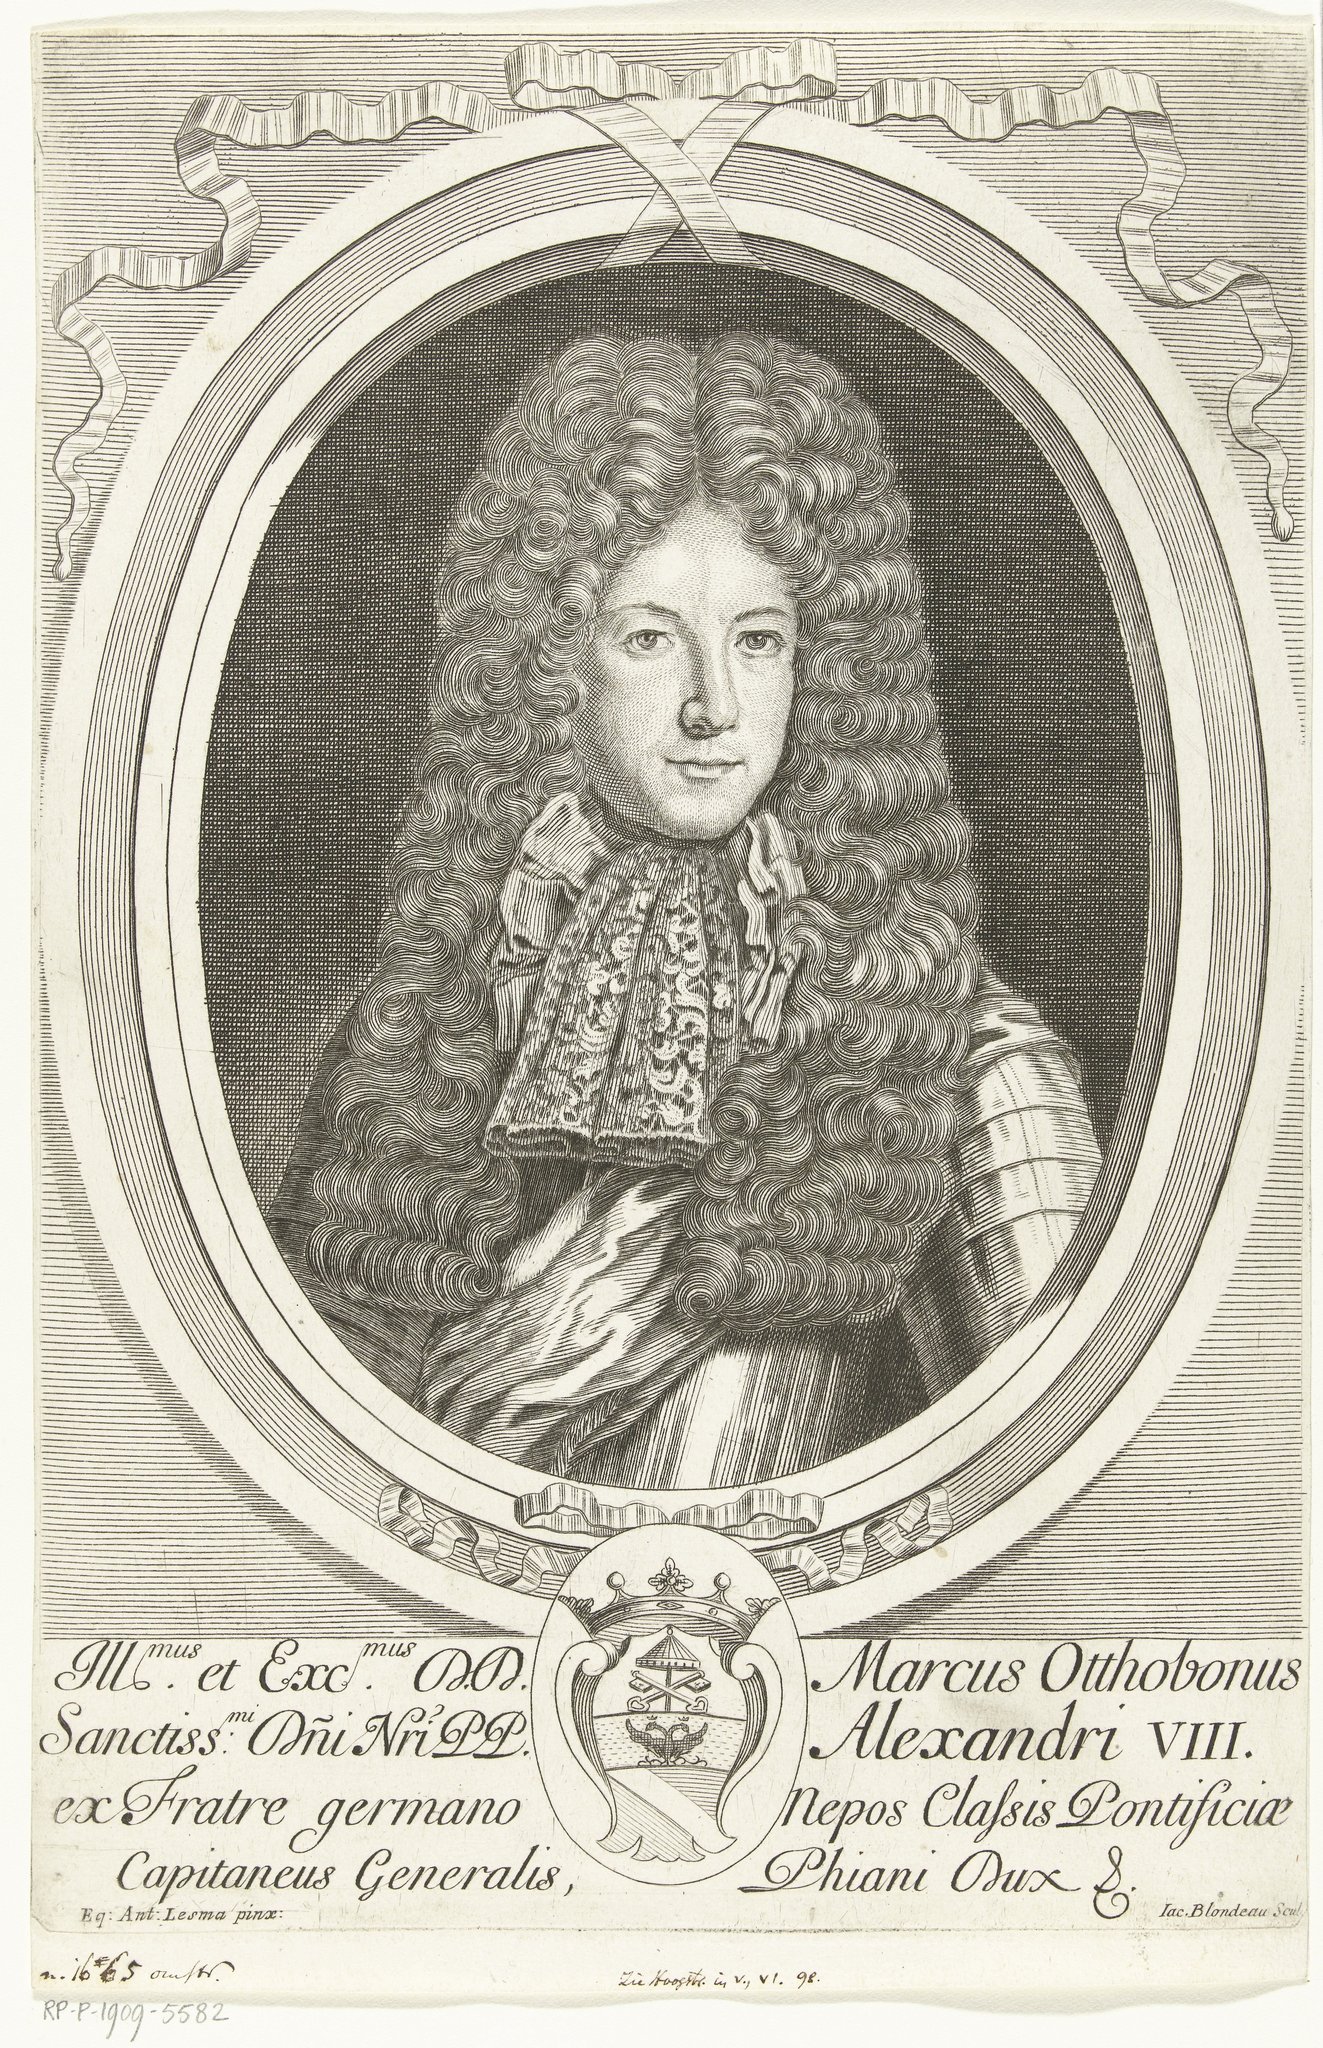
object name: print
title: Portret van Marco Ottoboni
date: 1665-1698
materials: paper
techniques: engraving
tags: marco ottoboni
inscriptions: collector's mark: Lugt 2228